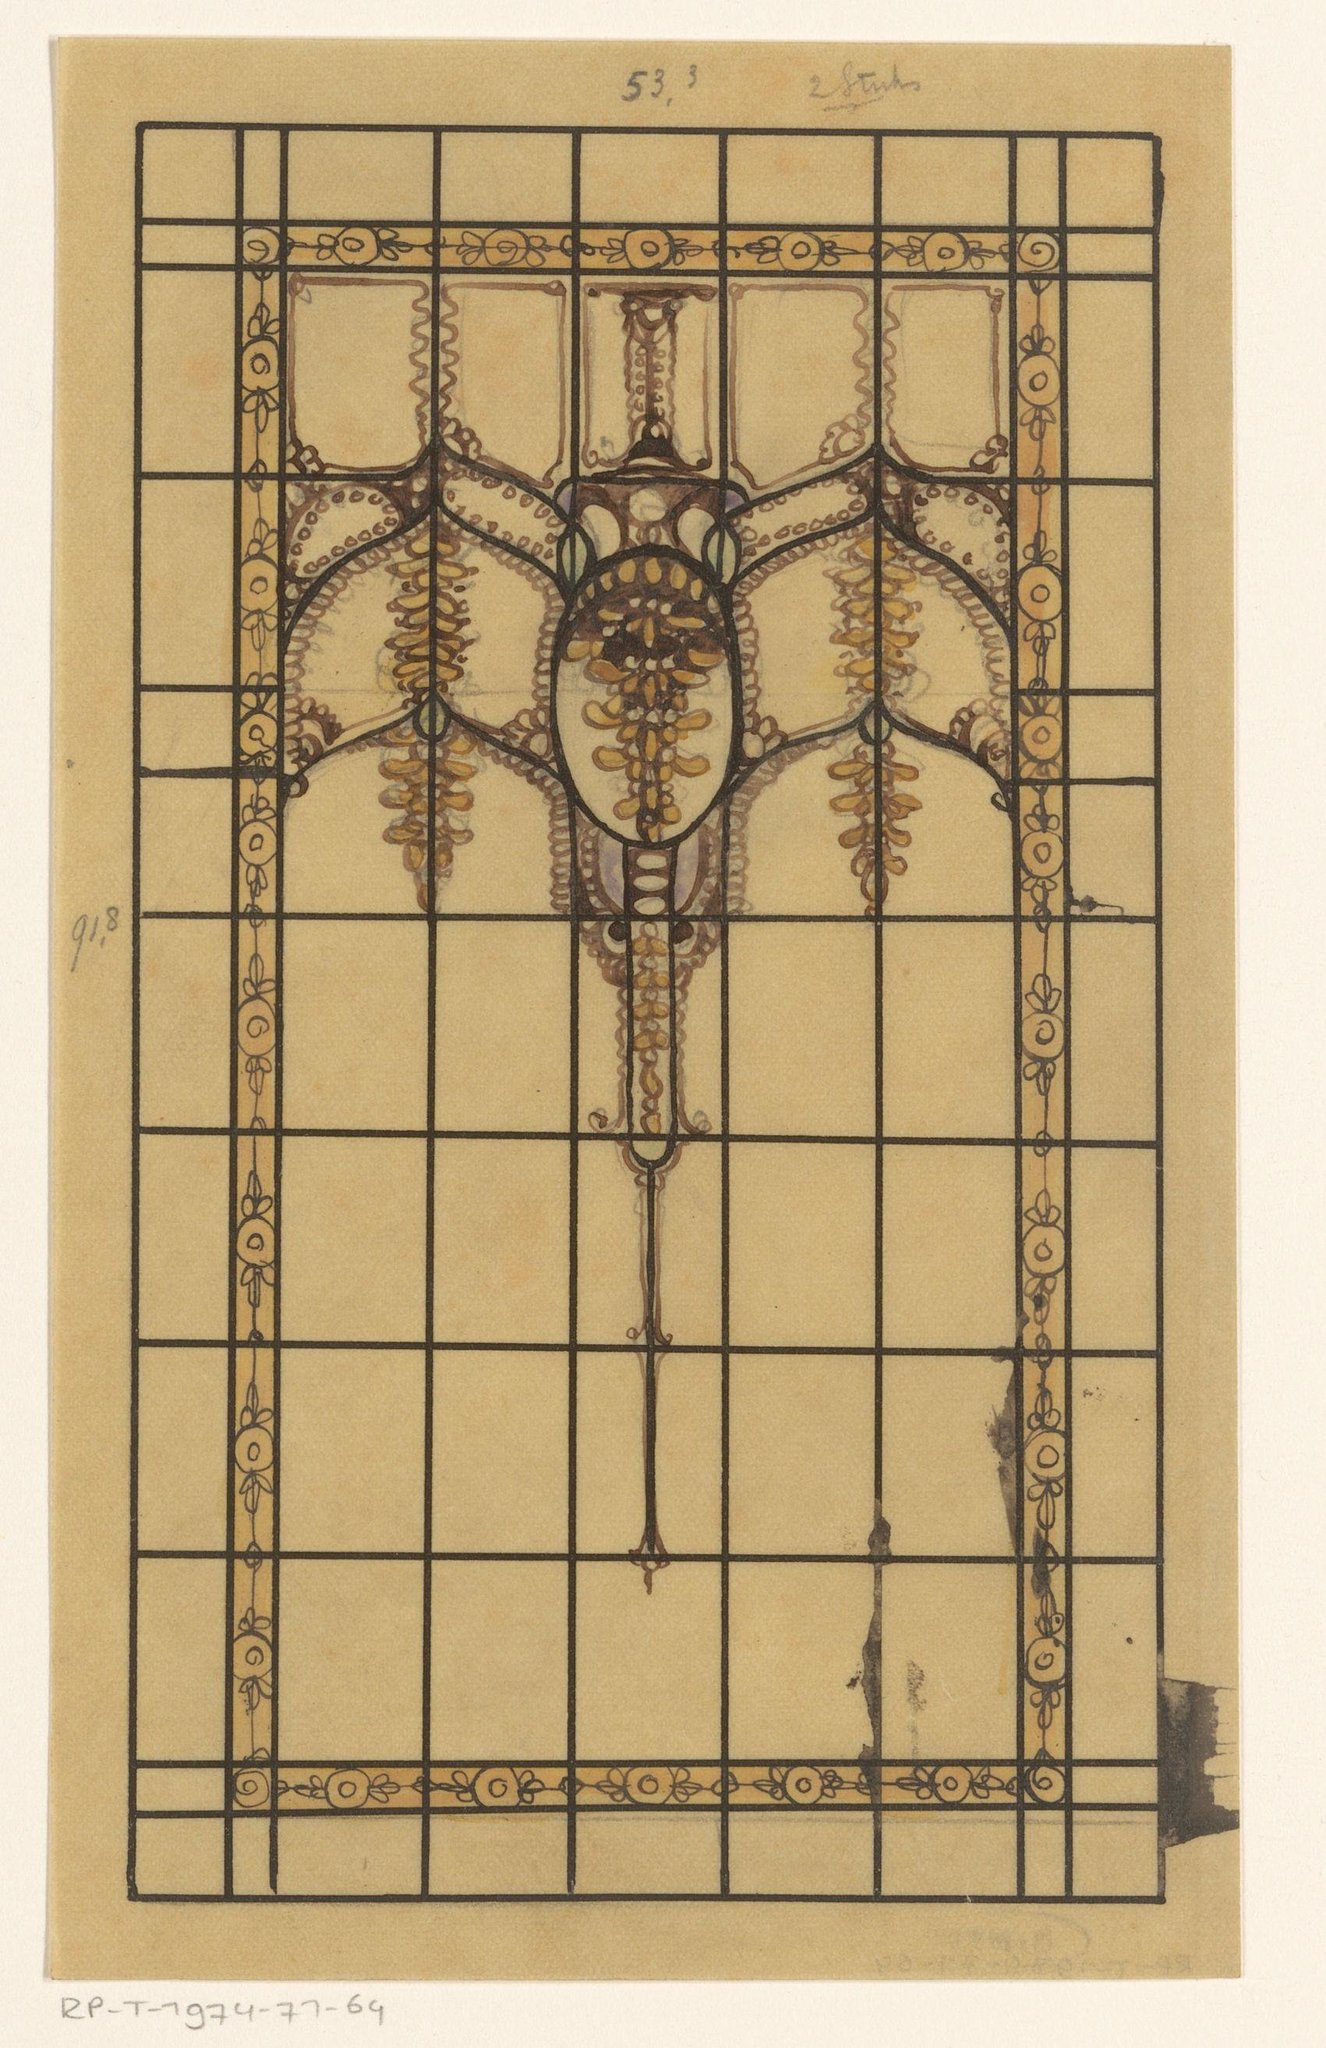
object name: drawing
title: Ontwerp voor een glas in loodraam met bloemornamenten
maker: Anonymous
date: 1907-1930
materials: ink, pencil, paper, watercolor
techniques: brush, pen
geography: amsterdam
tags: flowers ~ ornament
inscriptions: annotation, collector's mark: ‘R:MVS’